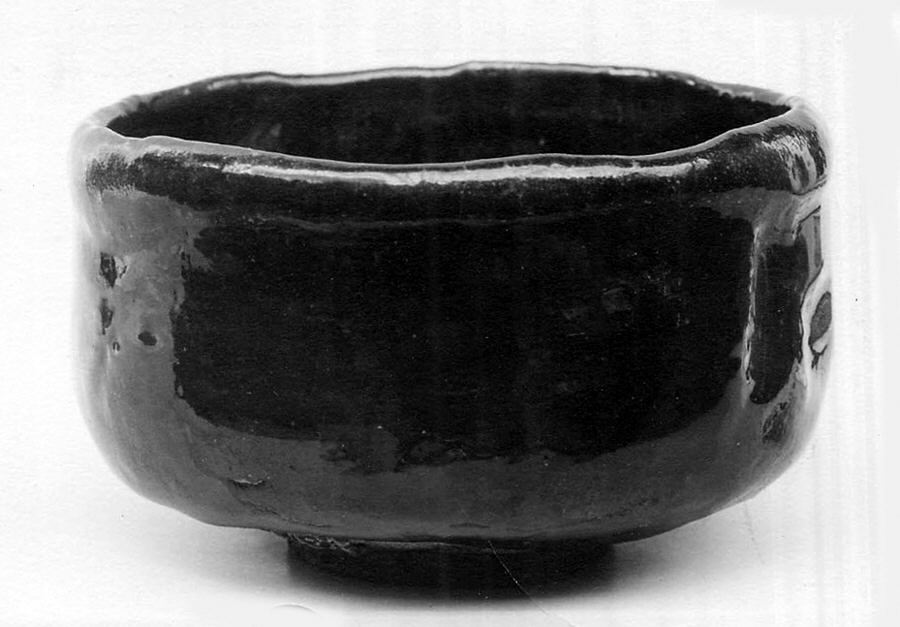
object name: teabowl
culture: japanese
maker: ubagamochi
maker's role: artist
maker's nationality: japanese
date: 1680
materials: clay, glaze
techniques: glazing